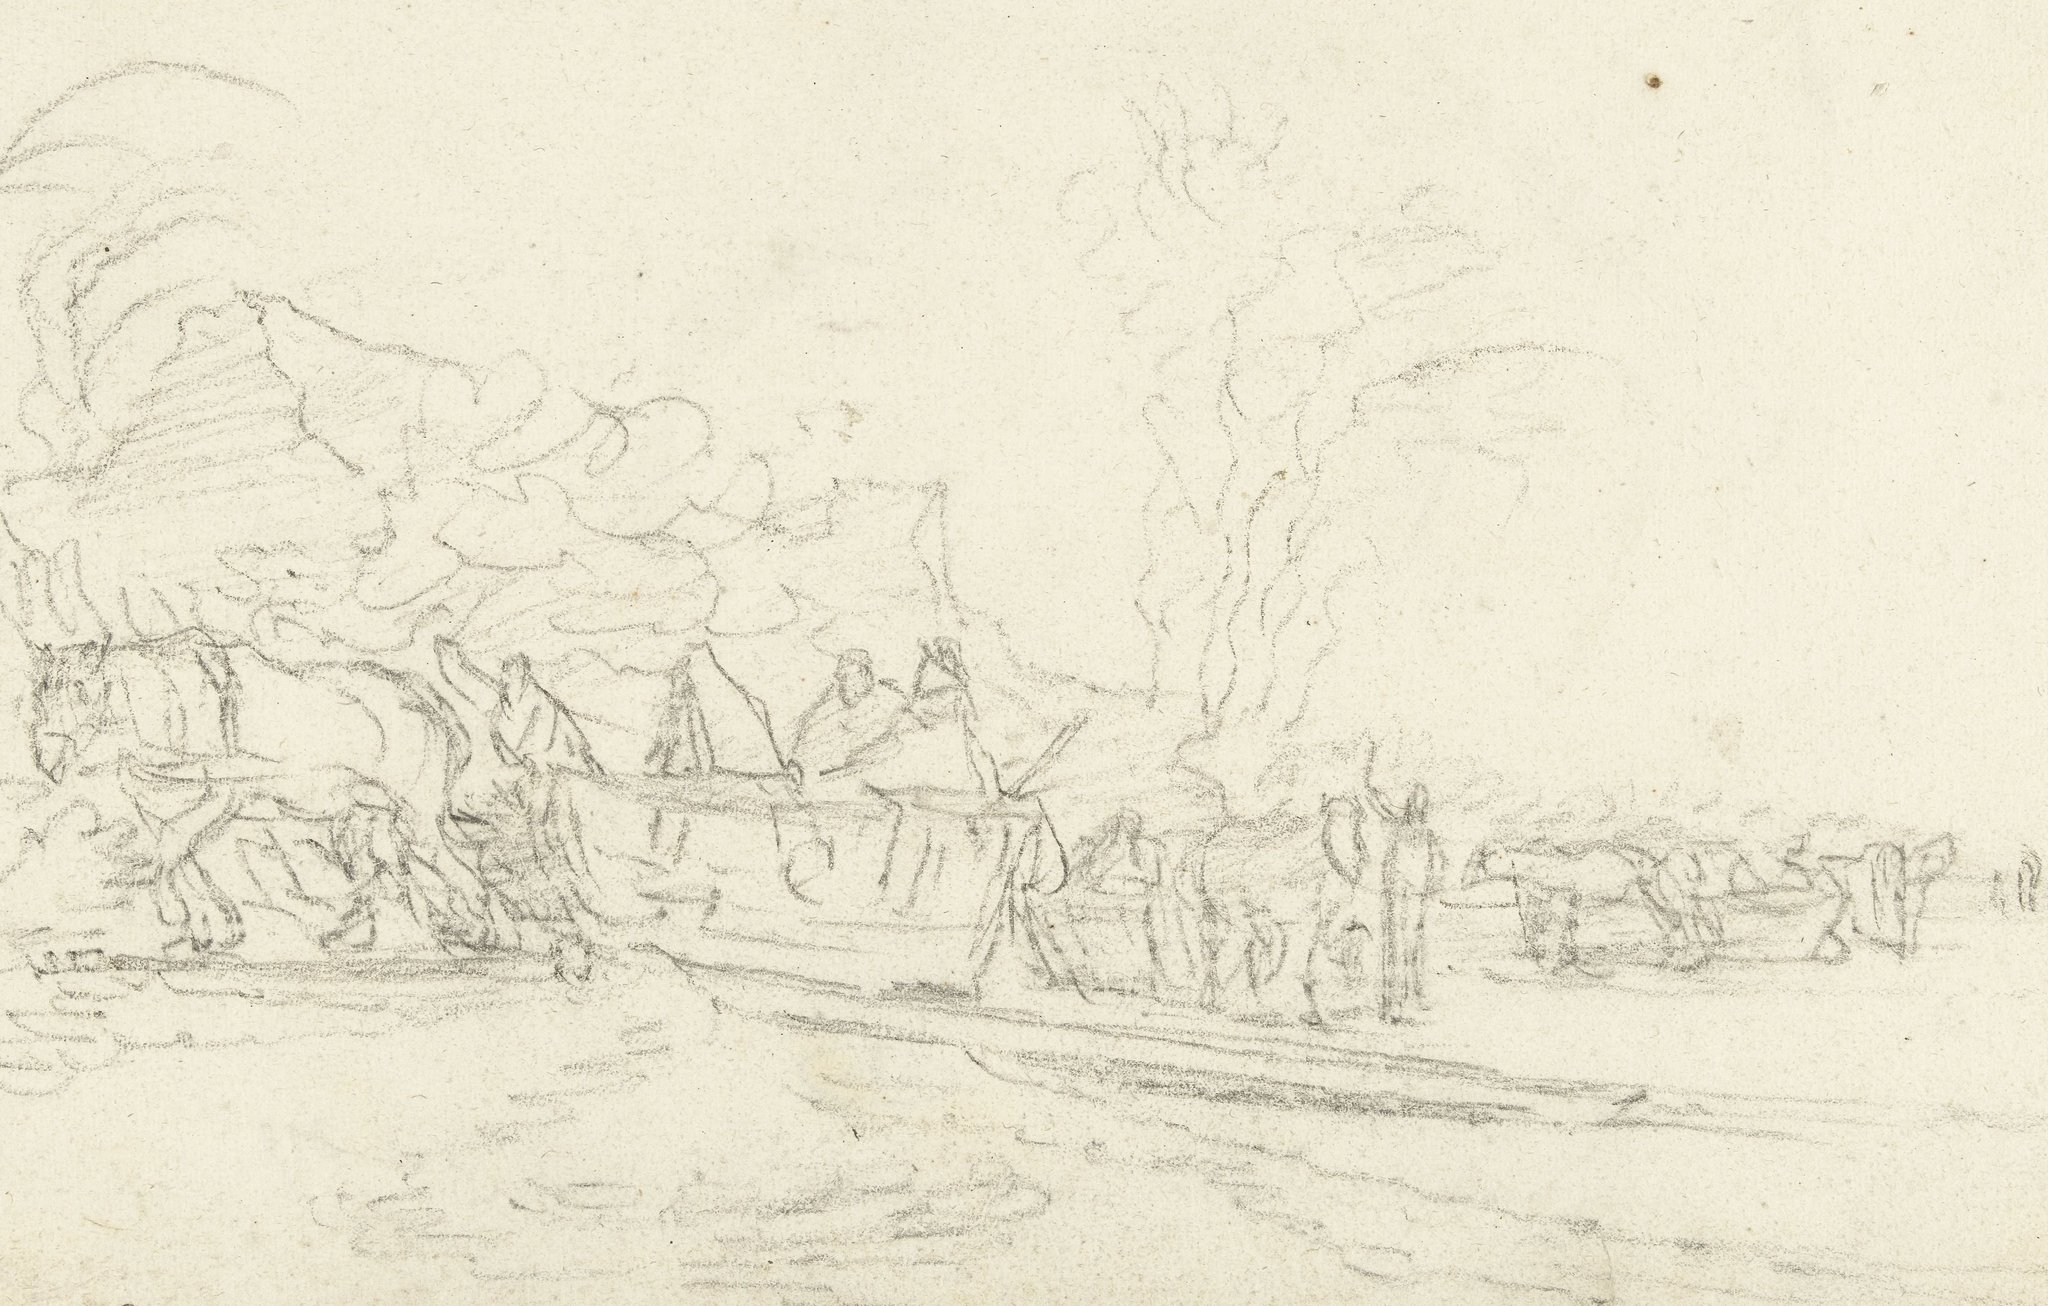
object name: drawing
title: Winters tafereel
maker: gerard ter borch (ii)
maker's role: draughtsman, painter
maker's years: 1617-1681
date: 1634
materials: chalk, paper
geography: haarlem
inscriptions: date and inscription: ‘P.(D.) Molyn. 1634’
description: Deel van een groep tekeningen (GJr 43-51) gemaakt in het atelier van Molijn. Aanvankelijk toegeschreven aan Pieter Molijn, vanwege de annotatie, maar waarschijnlijk door Gerard (II) gemaakt onder leiding van zijn leermeester Molijn in diens atelier.